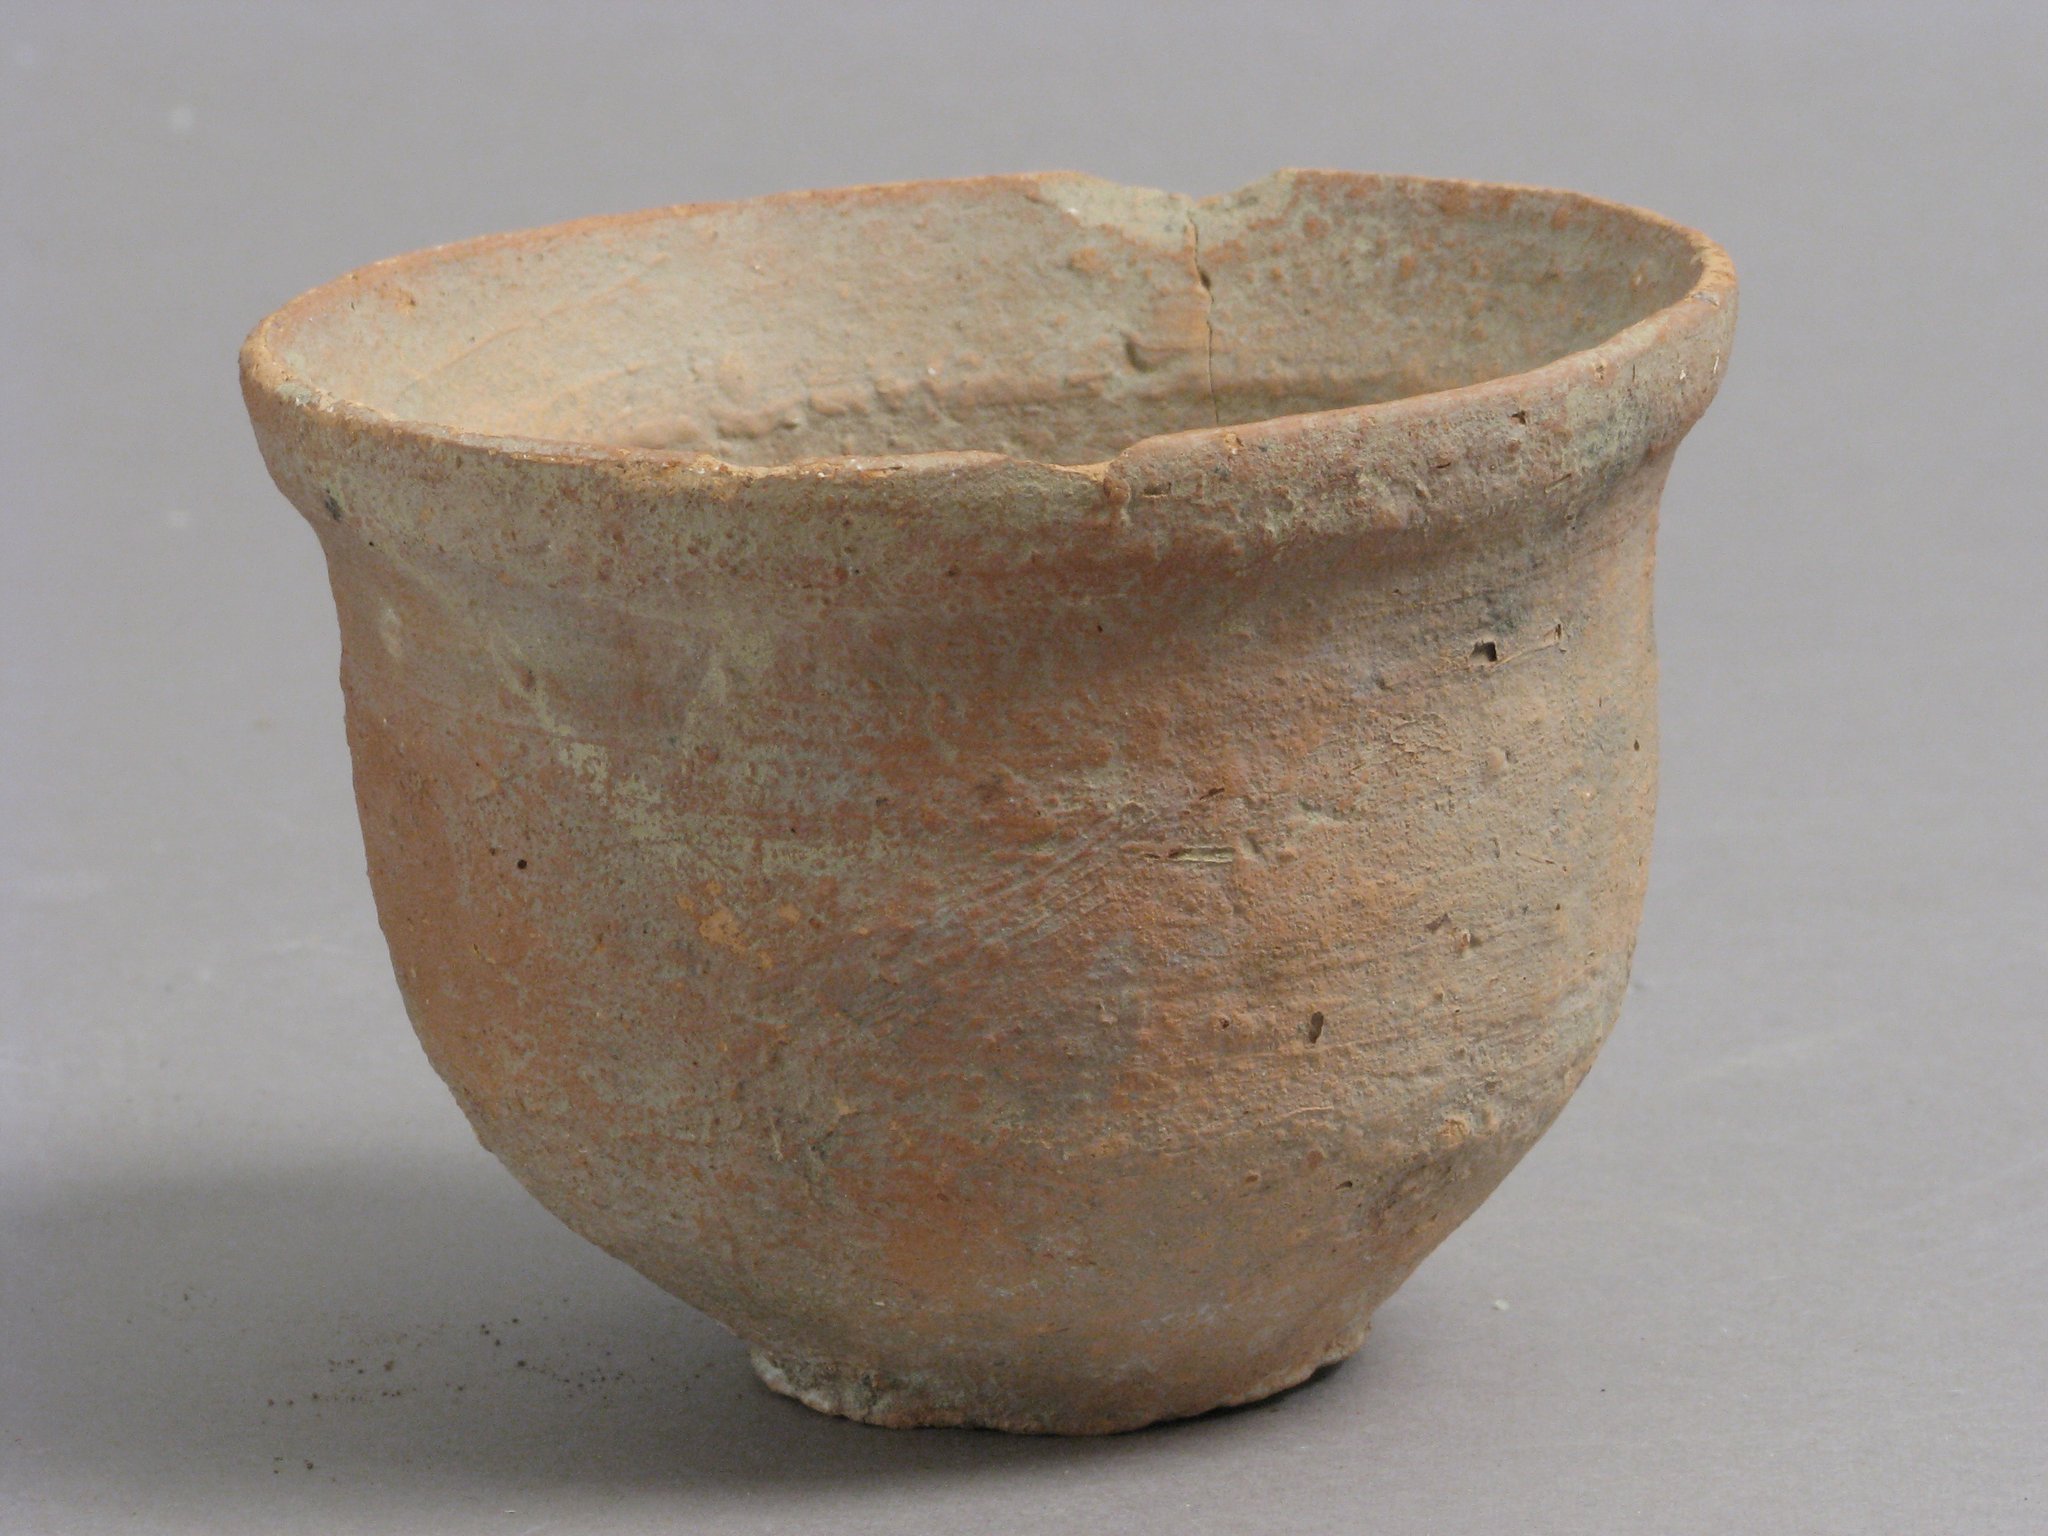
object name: bowl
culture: coptic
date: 301-700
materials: earthenware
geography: egypt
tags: bowls